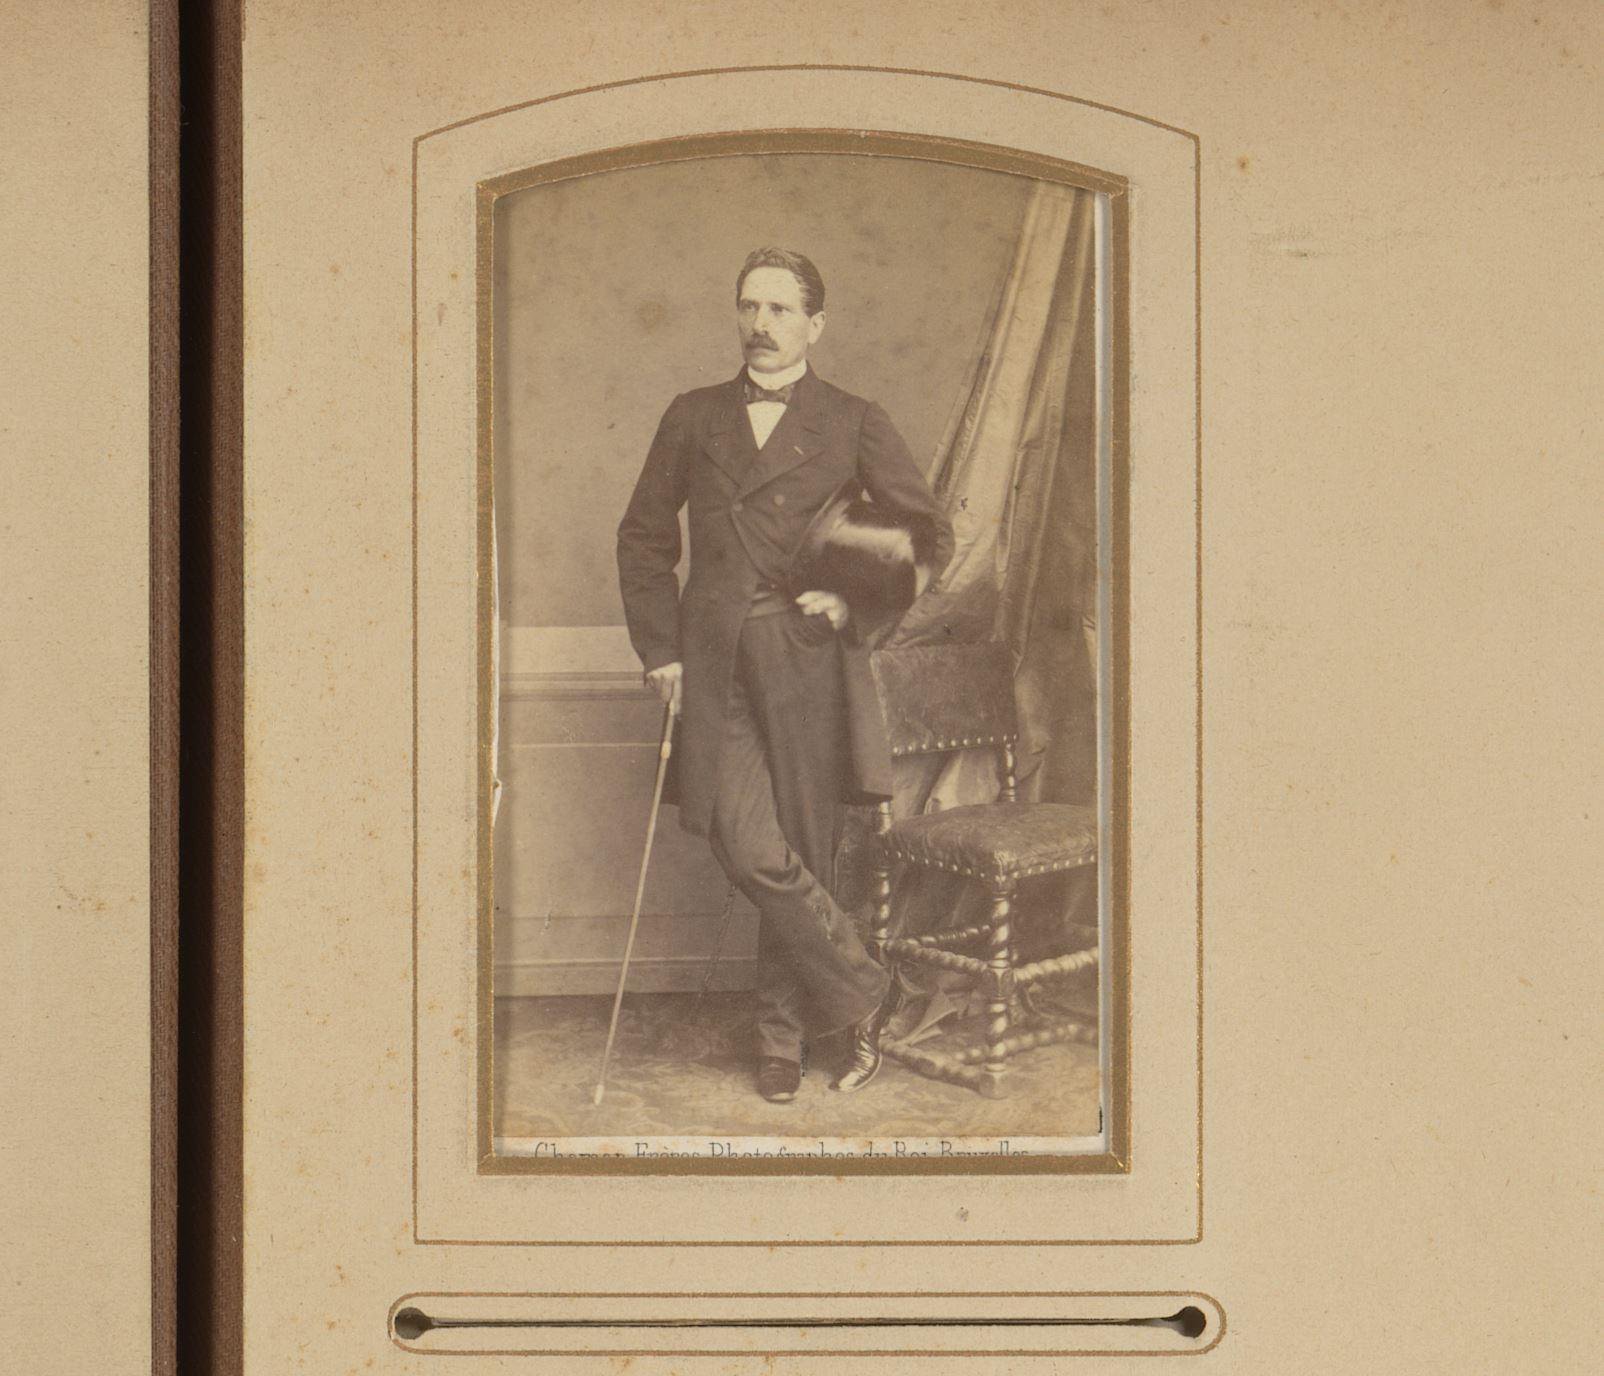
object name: album leaf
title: Portret van een staande man met wandelstok en hoge hoed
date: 1860-1894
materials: cardboard, photographic support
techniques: albumen print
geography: brussels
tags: walking-stick, staff, historical persons, head-gear: top hat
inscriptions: inscription: ‘ATELIER DE PHOTOGRAPHIE/ GHÉMAR FRÈRES,/ PHOTOGRAPHES DU ROI,/ 27, rue de l'Ecuyer,/ entrée par la porte cochère,/ BRUXELLES.’